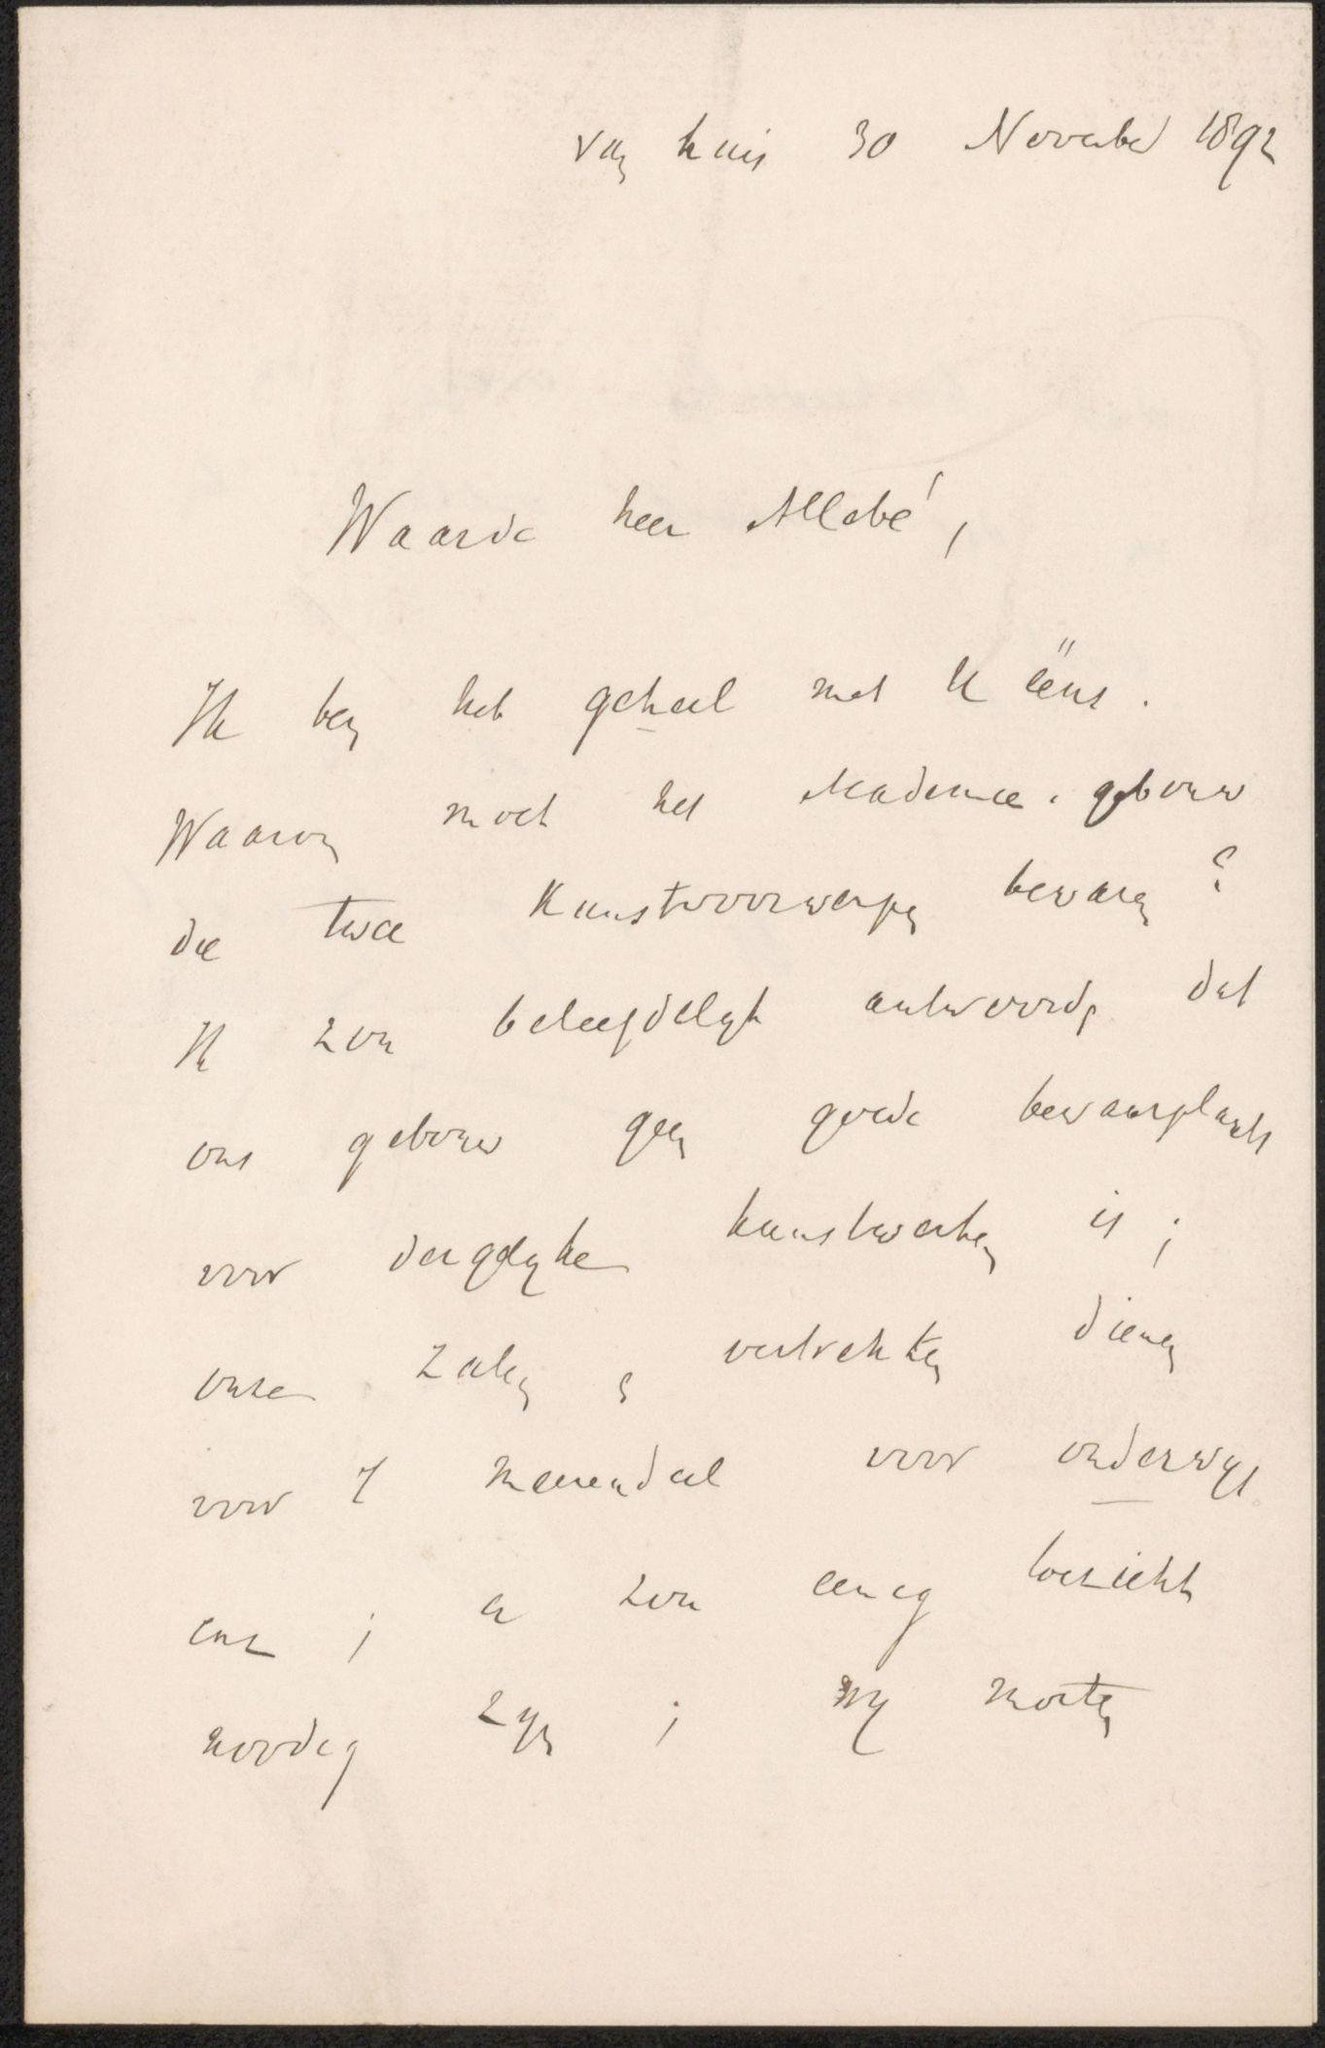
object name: letter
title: Brief aan August Allebé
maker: hendrick peter godfried quack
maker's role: econoom, geschiedschrijver, hoogleraar, jurist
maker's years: 1834-1917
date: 1892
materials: ink, paper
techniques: pen, writing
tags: amsterdam, print maker, draughtsman, august allebé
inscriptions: watermark